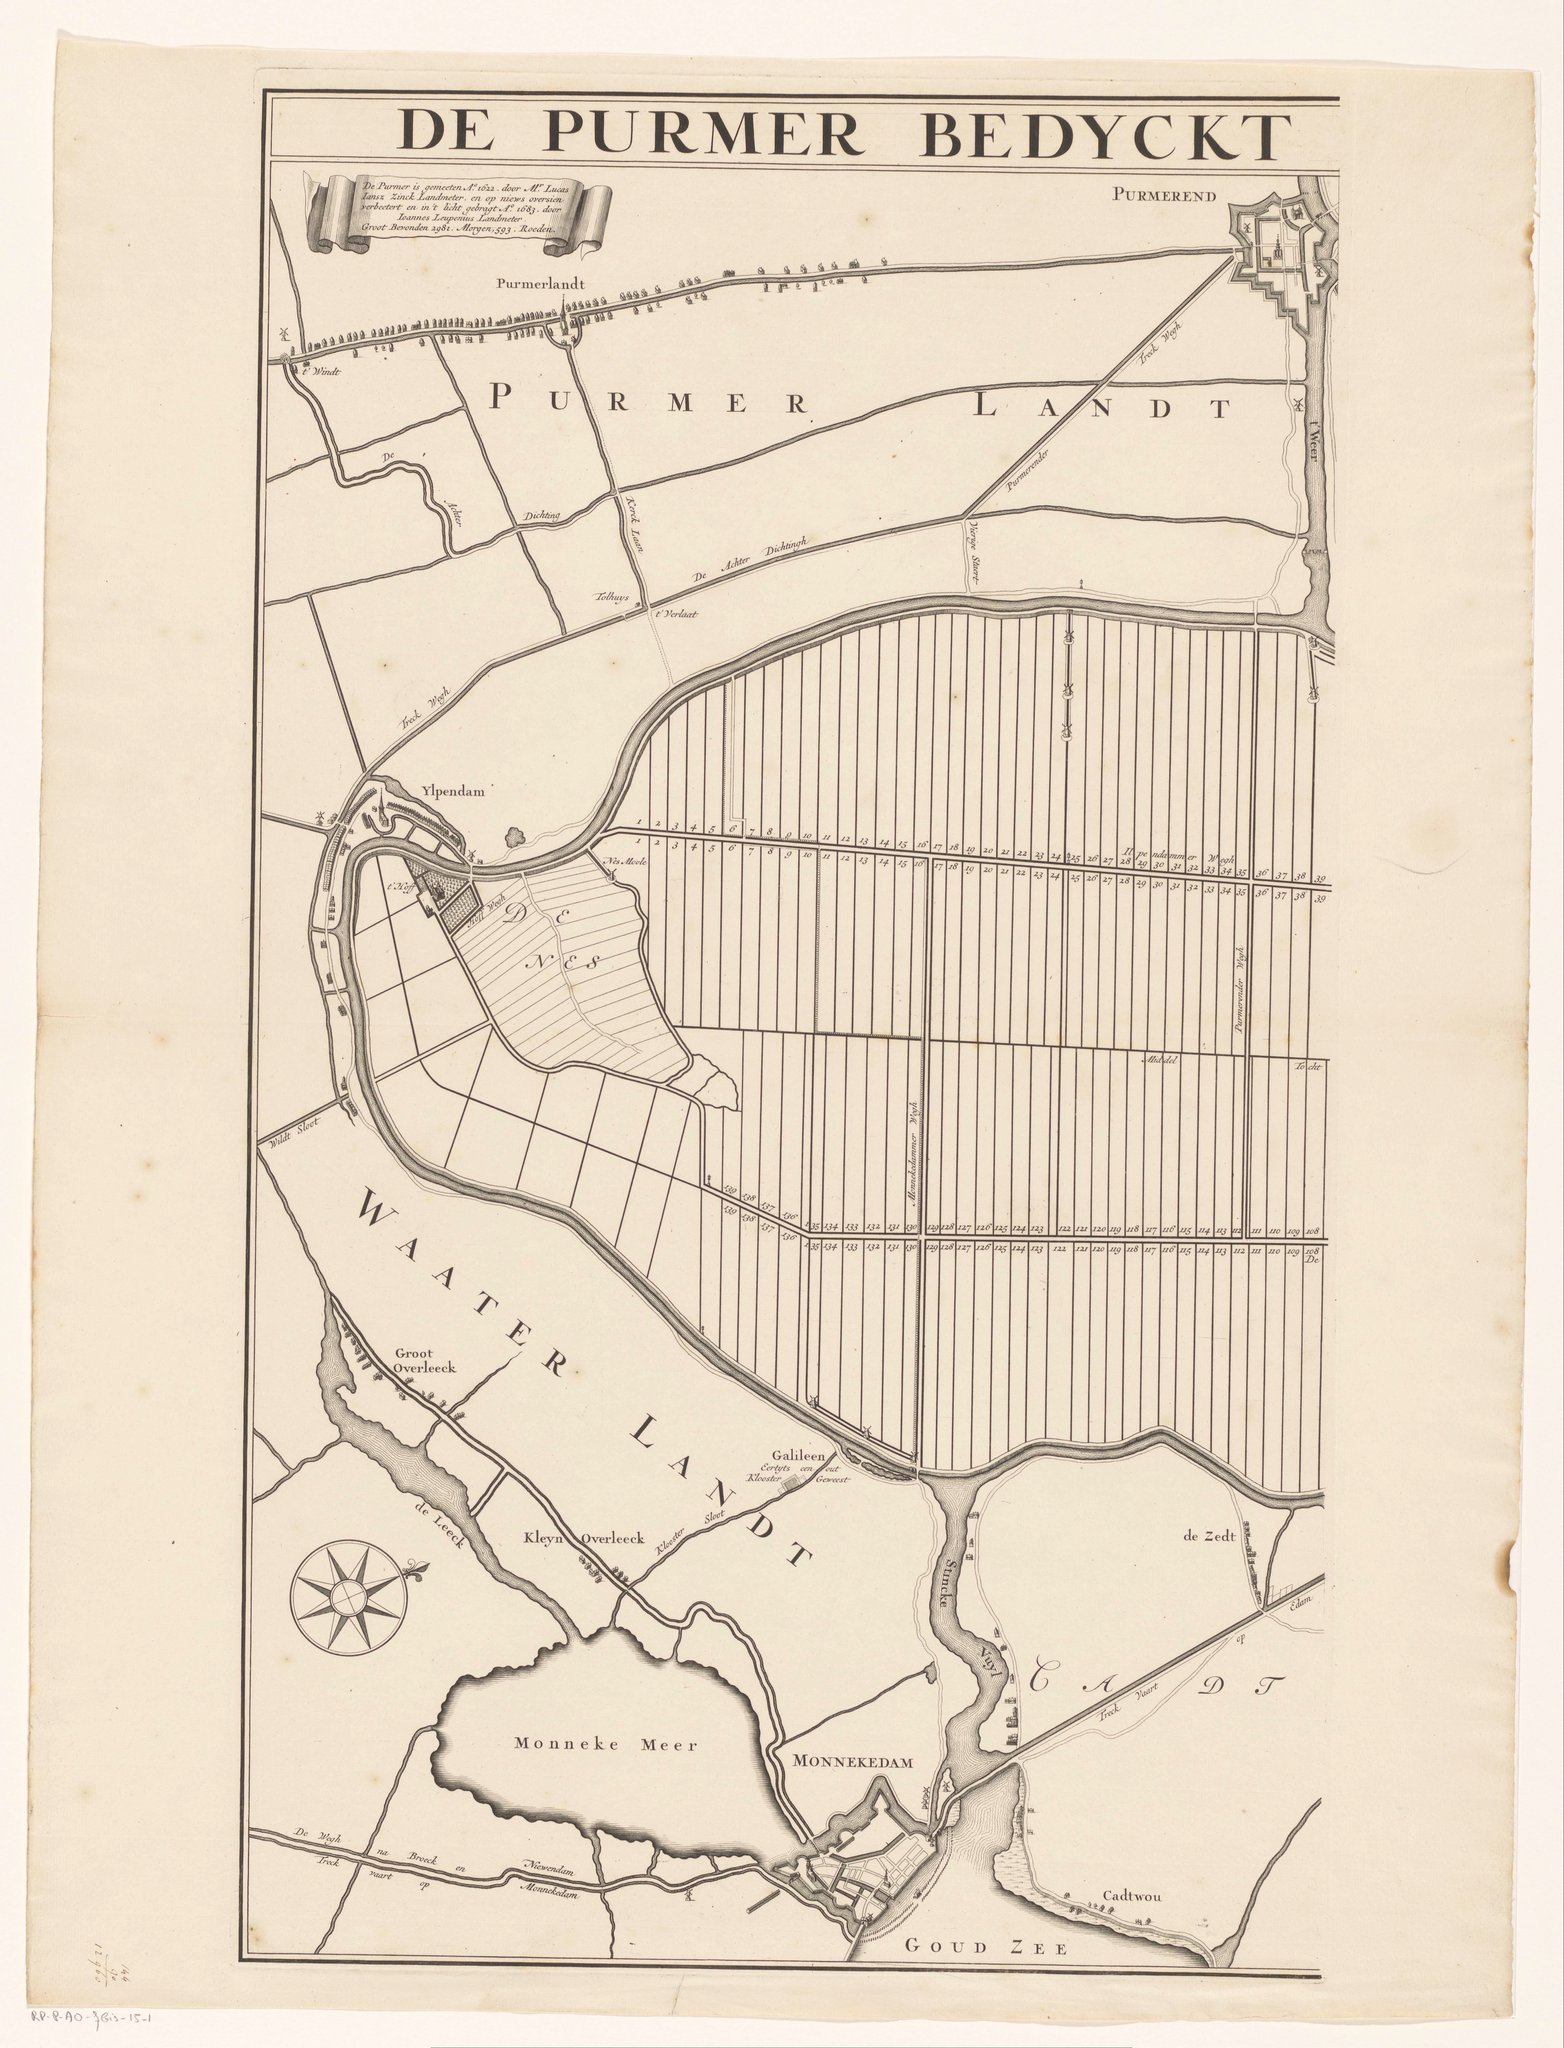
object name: print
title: De Purmer bedyckt inde jaare M.D.C.XVIII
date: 1683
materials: paper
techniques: engraving, etching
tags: maps of separate countries or regions, polder, reclaimed land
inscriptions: collector's mark: Lugt 195